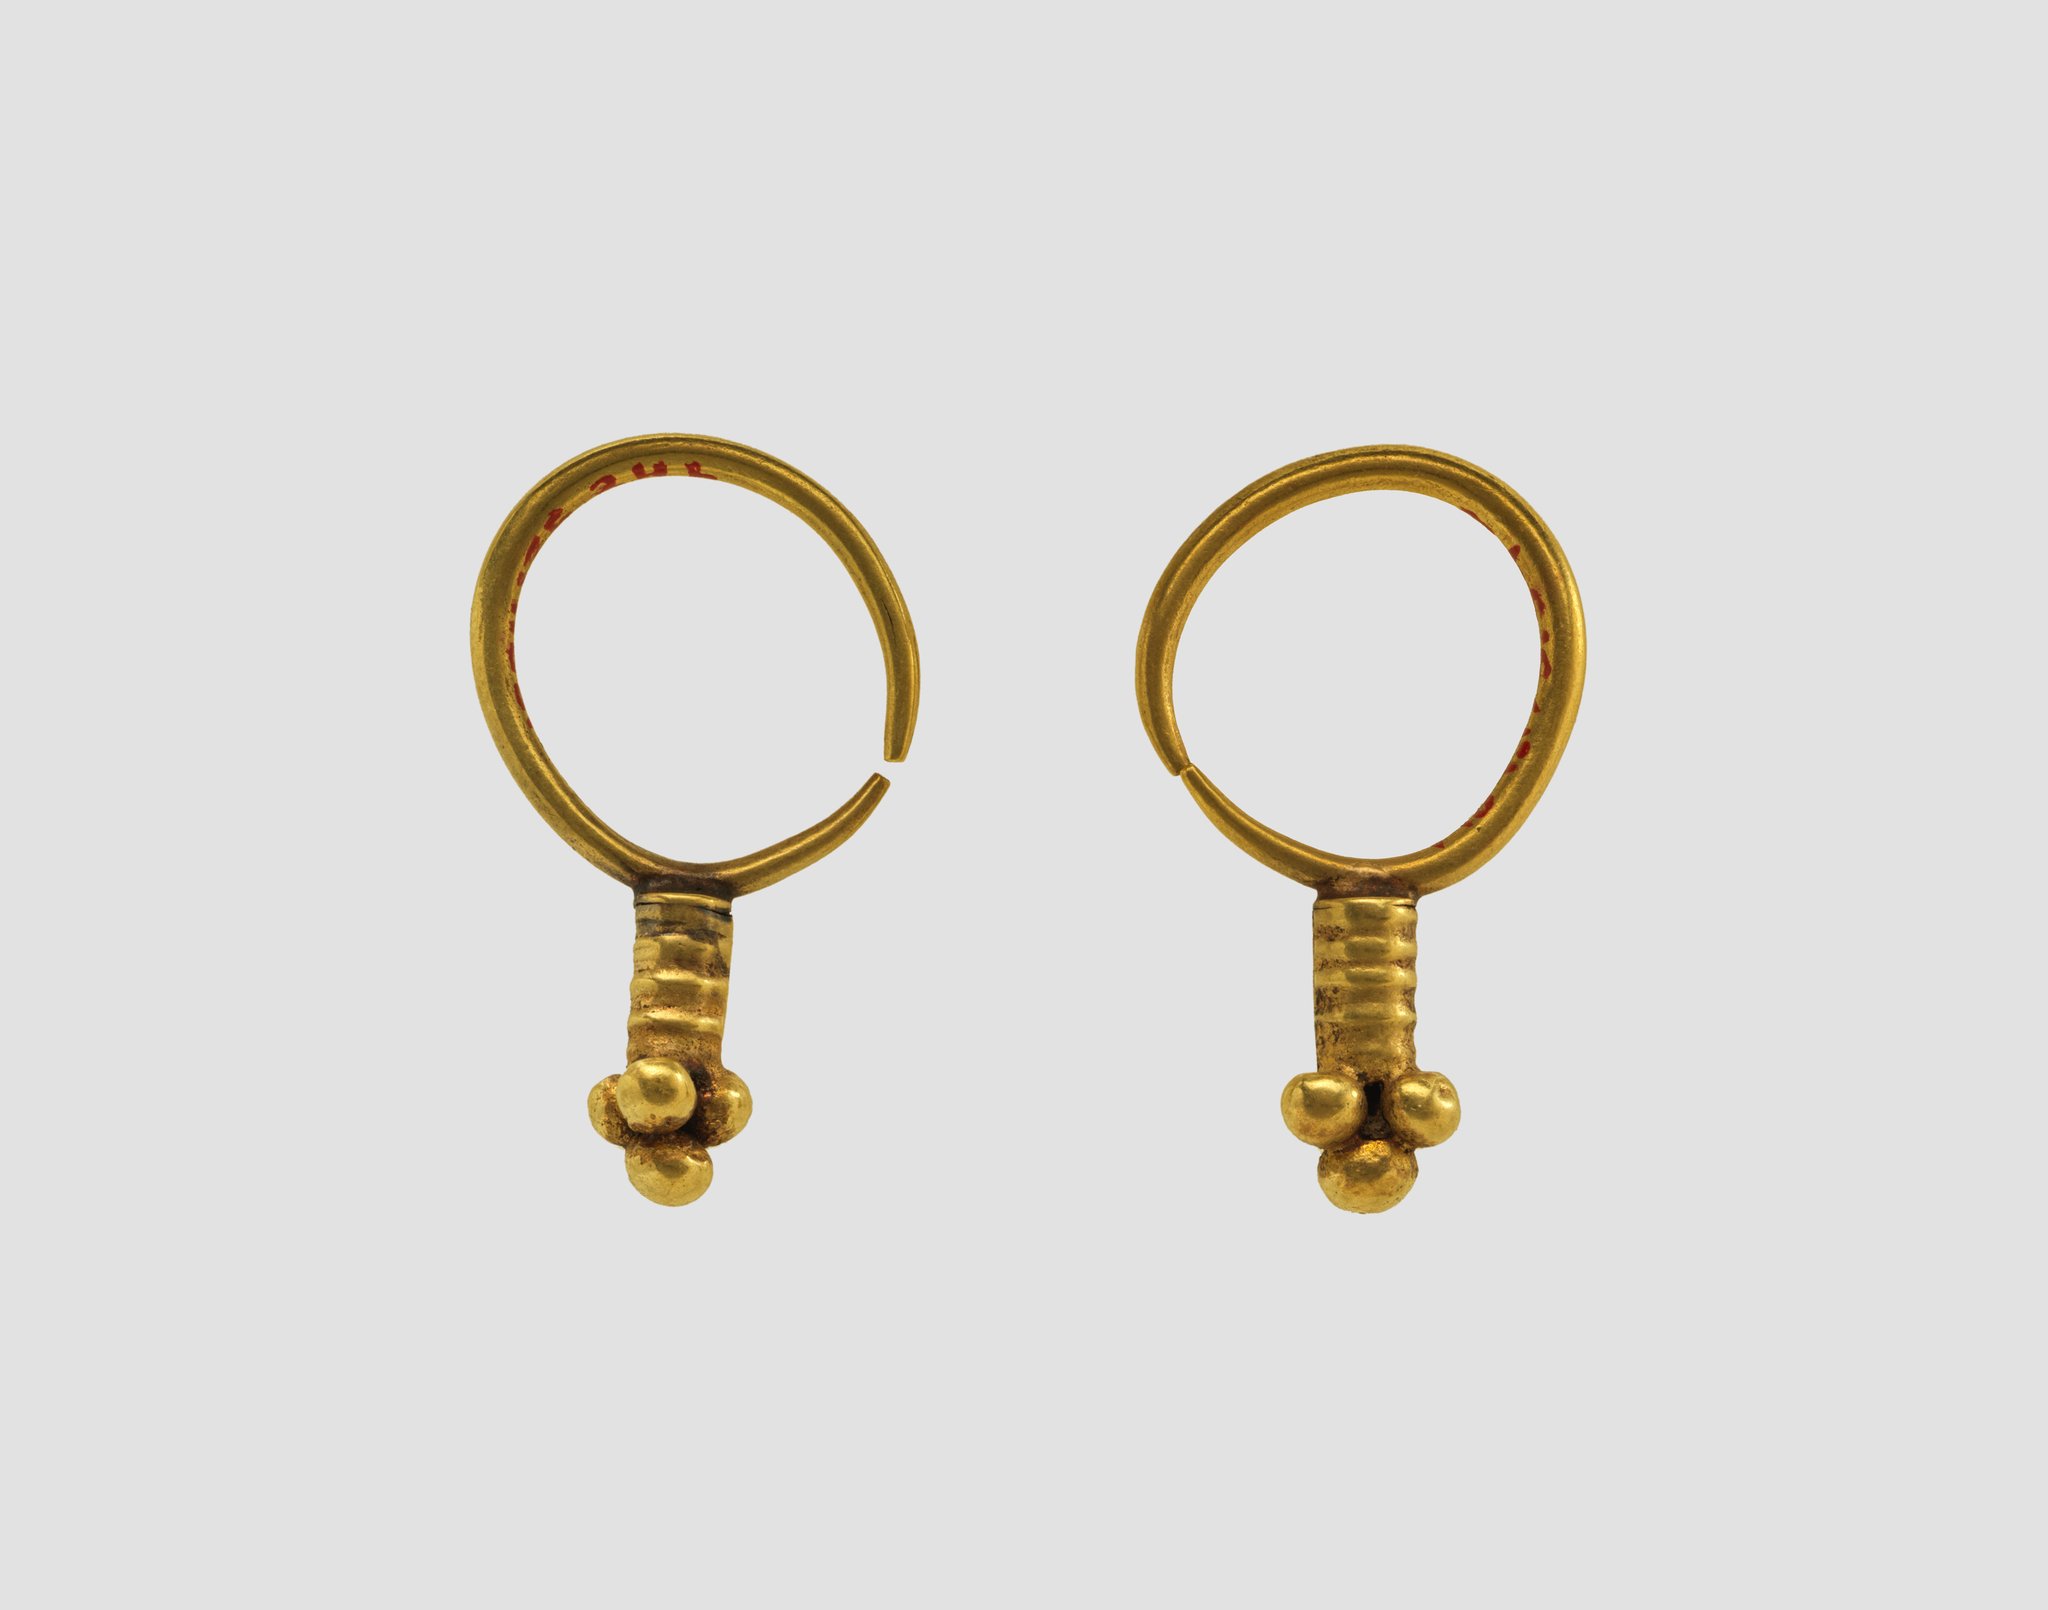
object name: earring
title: Earrings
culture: iranian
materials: gold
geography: iran